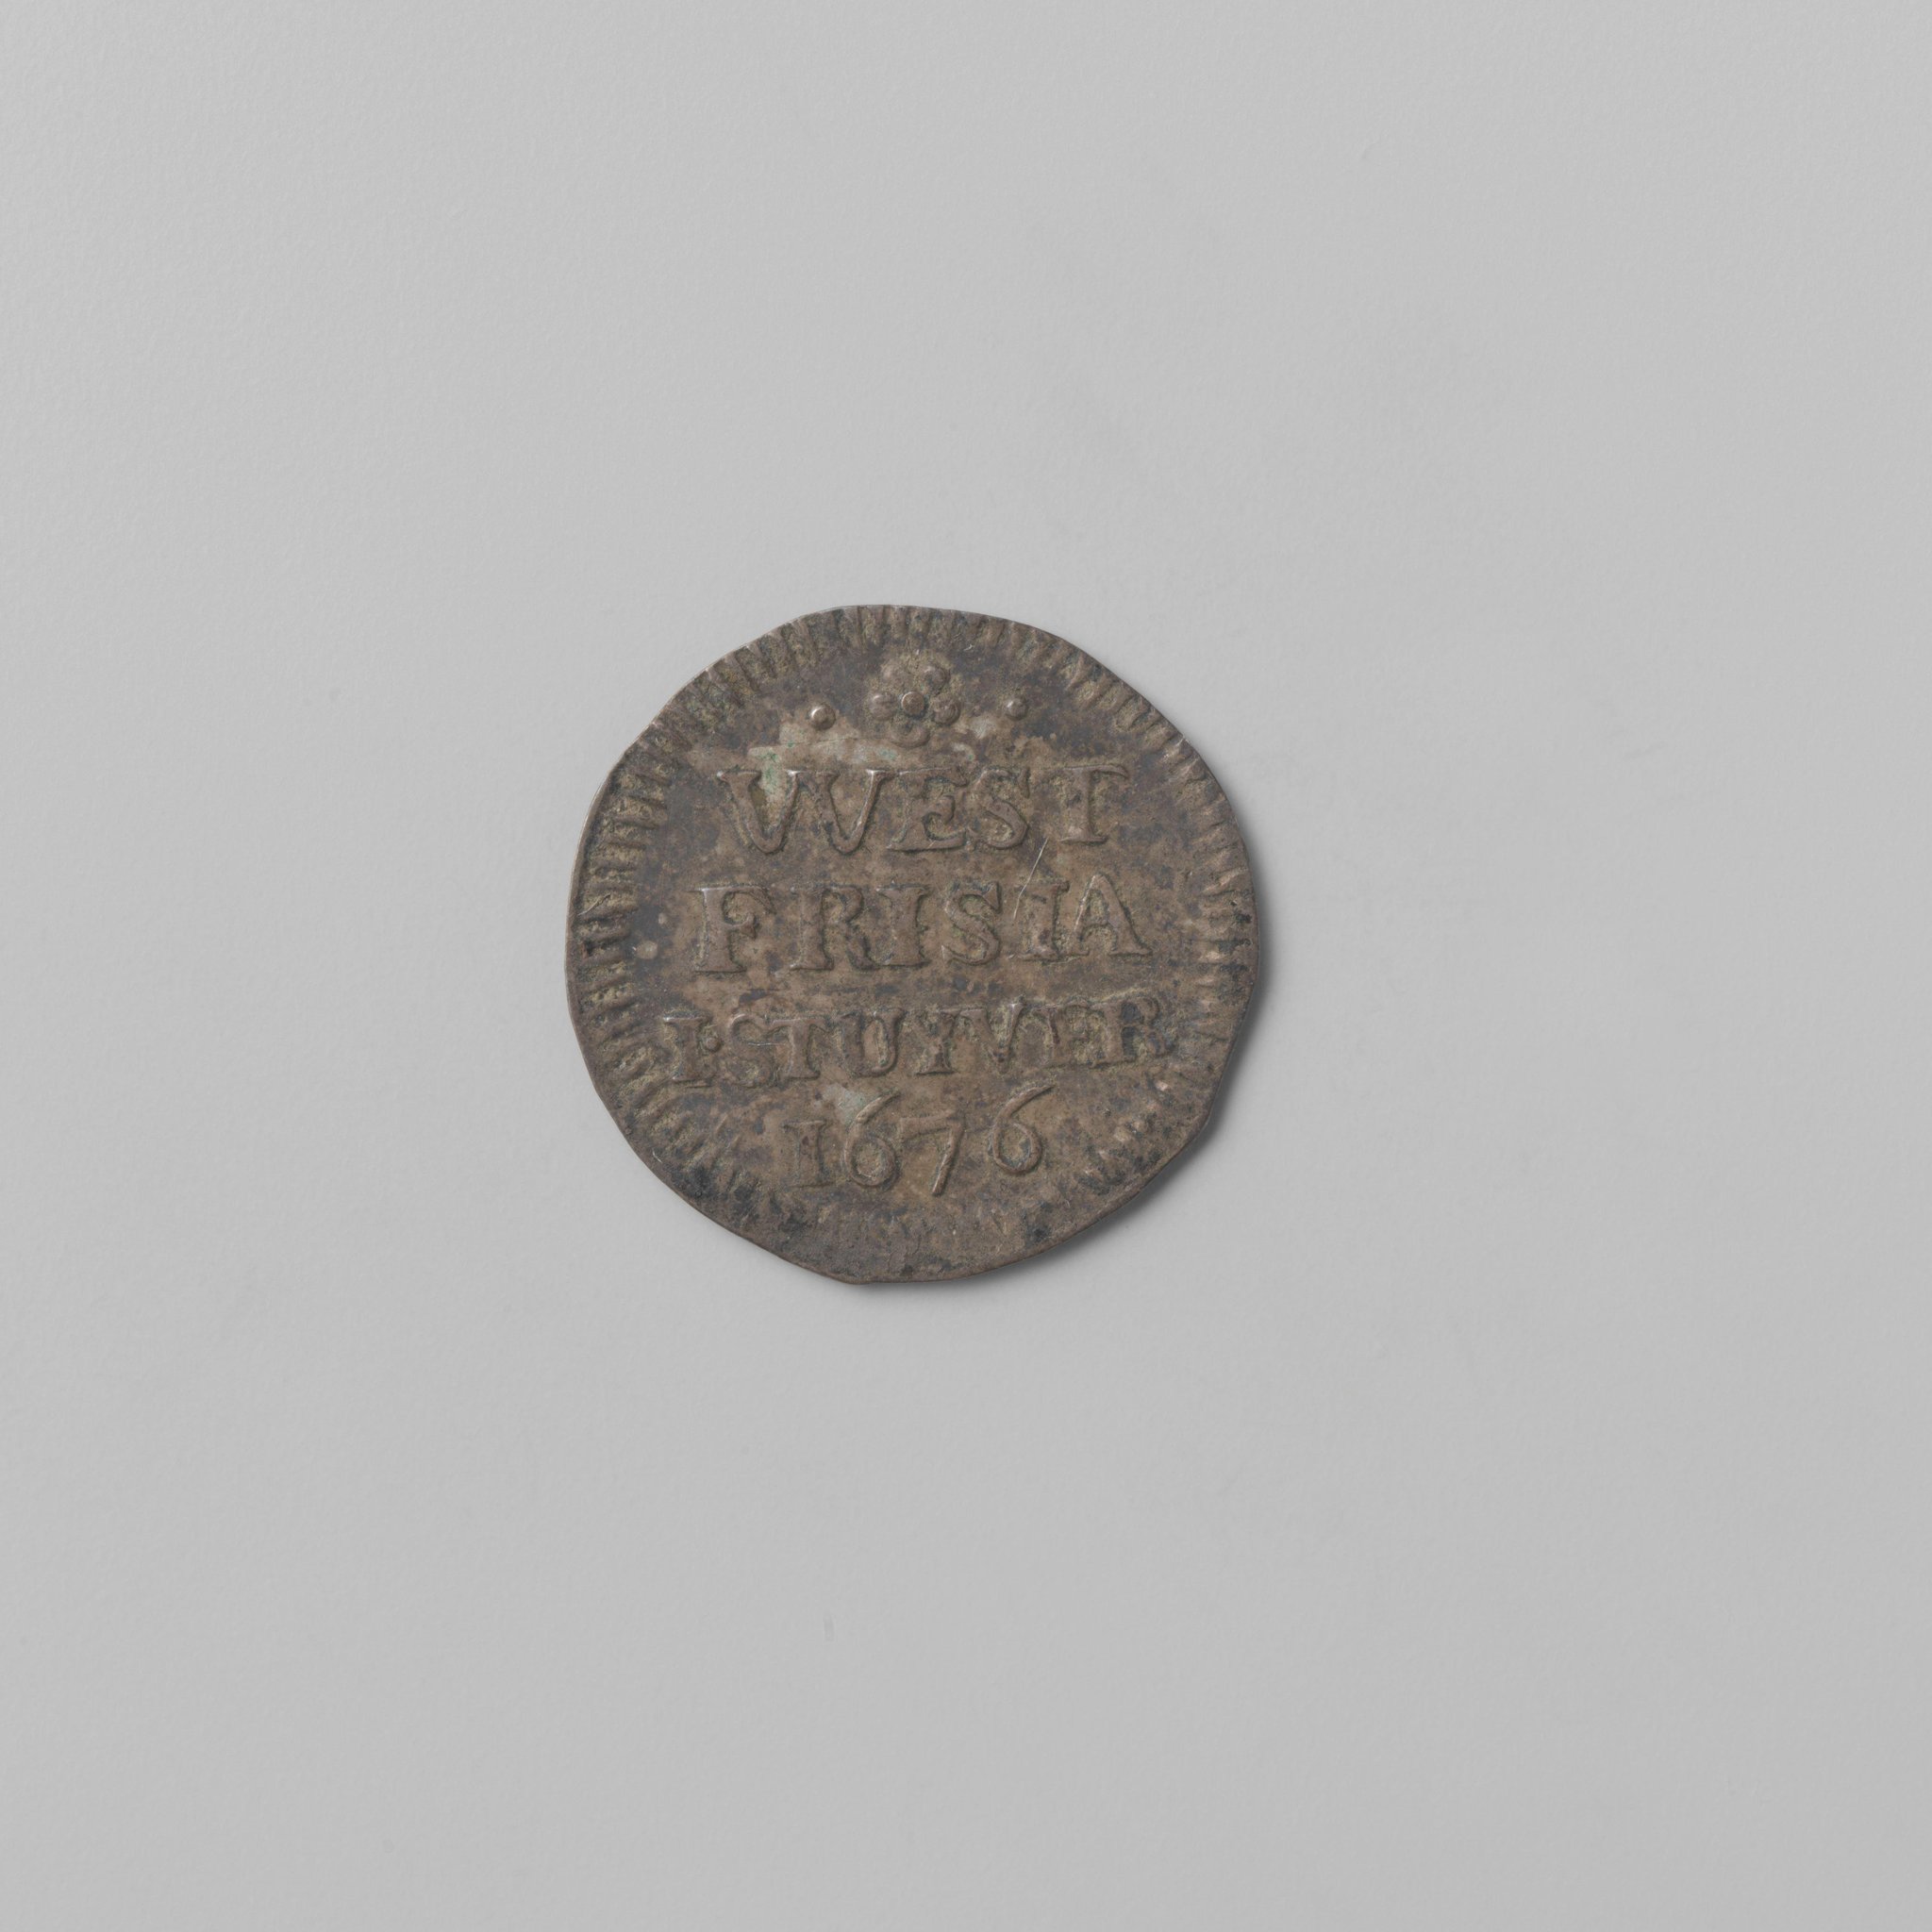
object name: coin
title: Westfriese stuiver, 1676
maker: dirck bosch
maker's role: mintmaster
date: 1676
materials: silver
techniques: striking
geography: enkhuizen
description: Zilveren munt. Voorzijde: tussen letters B en P gekroond wapenschild van West-Friesland. Keerzijde: Opschrift in twee regels.Daaronder waarde-aanduiding en jaartal. Daarboven een rozet tussen twee punten.